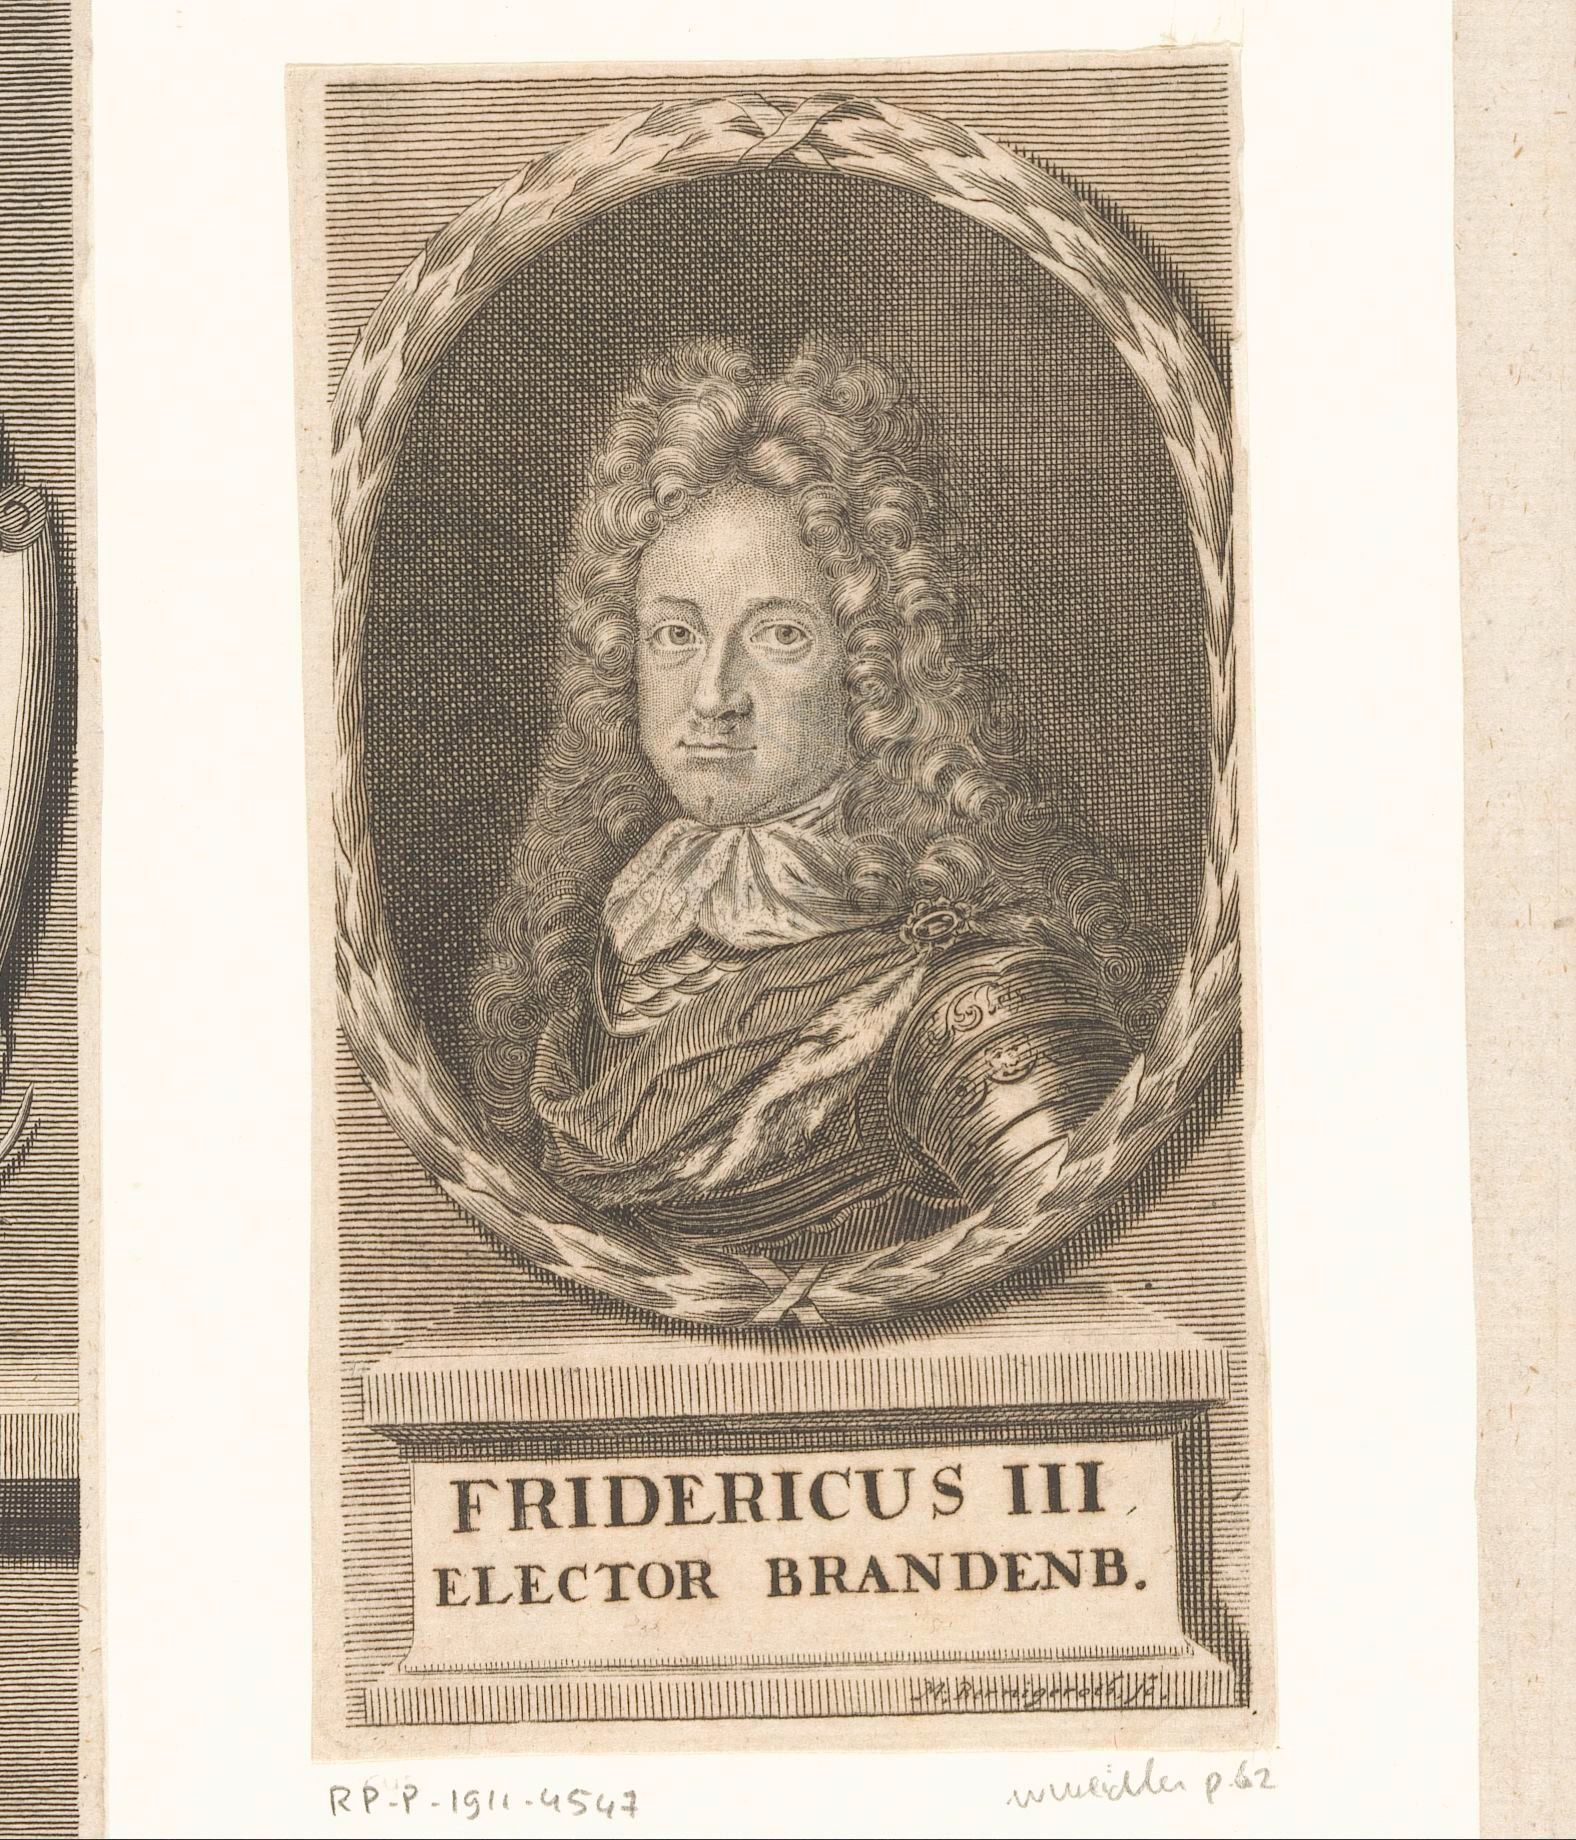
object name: print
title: Portret van Friedrich III, keurvorst van Brandenburg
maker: johann martin bernigeroth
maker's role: print maker, publisher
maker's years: 1713-1767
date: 1688-1701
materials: paper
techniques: engraving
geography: leipzig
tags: frederik i koning van pruisen, armour, historical persons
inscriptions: collector's mark: Lugt 2228